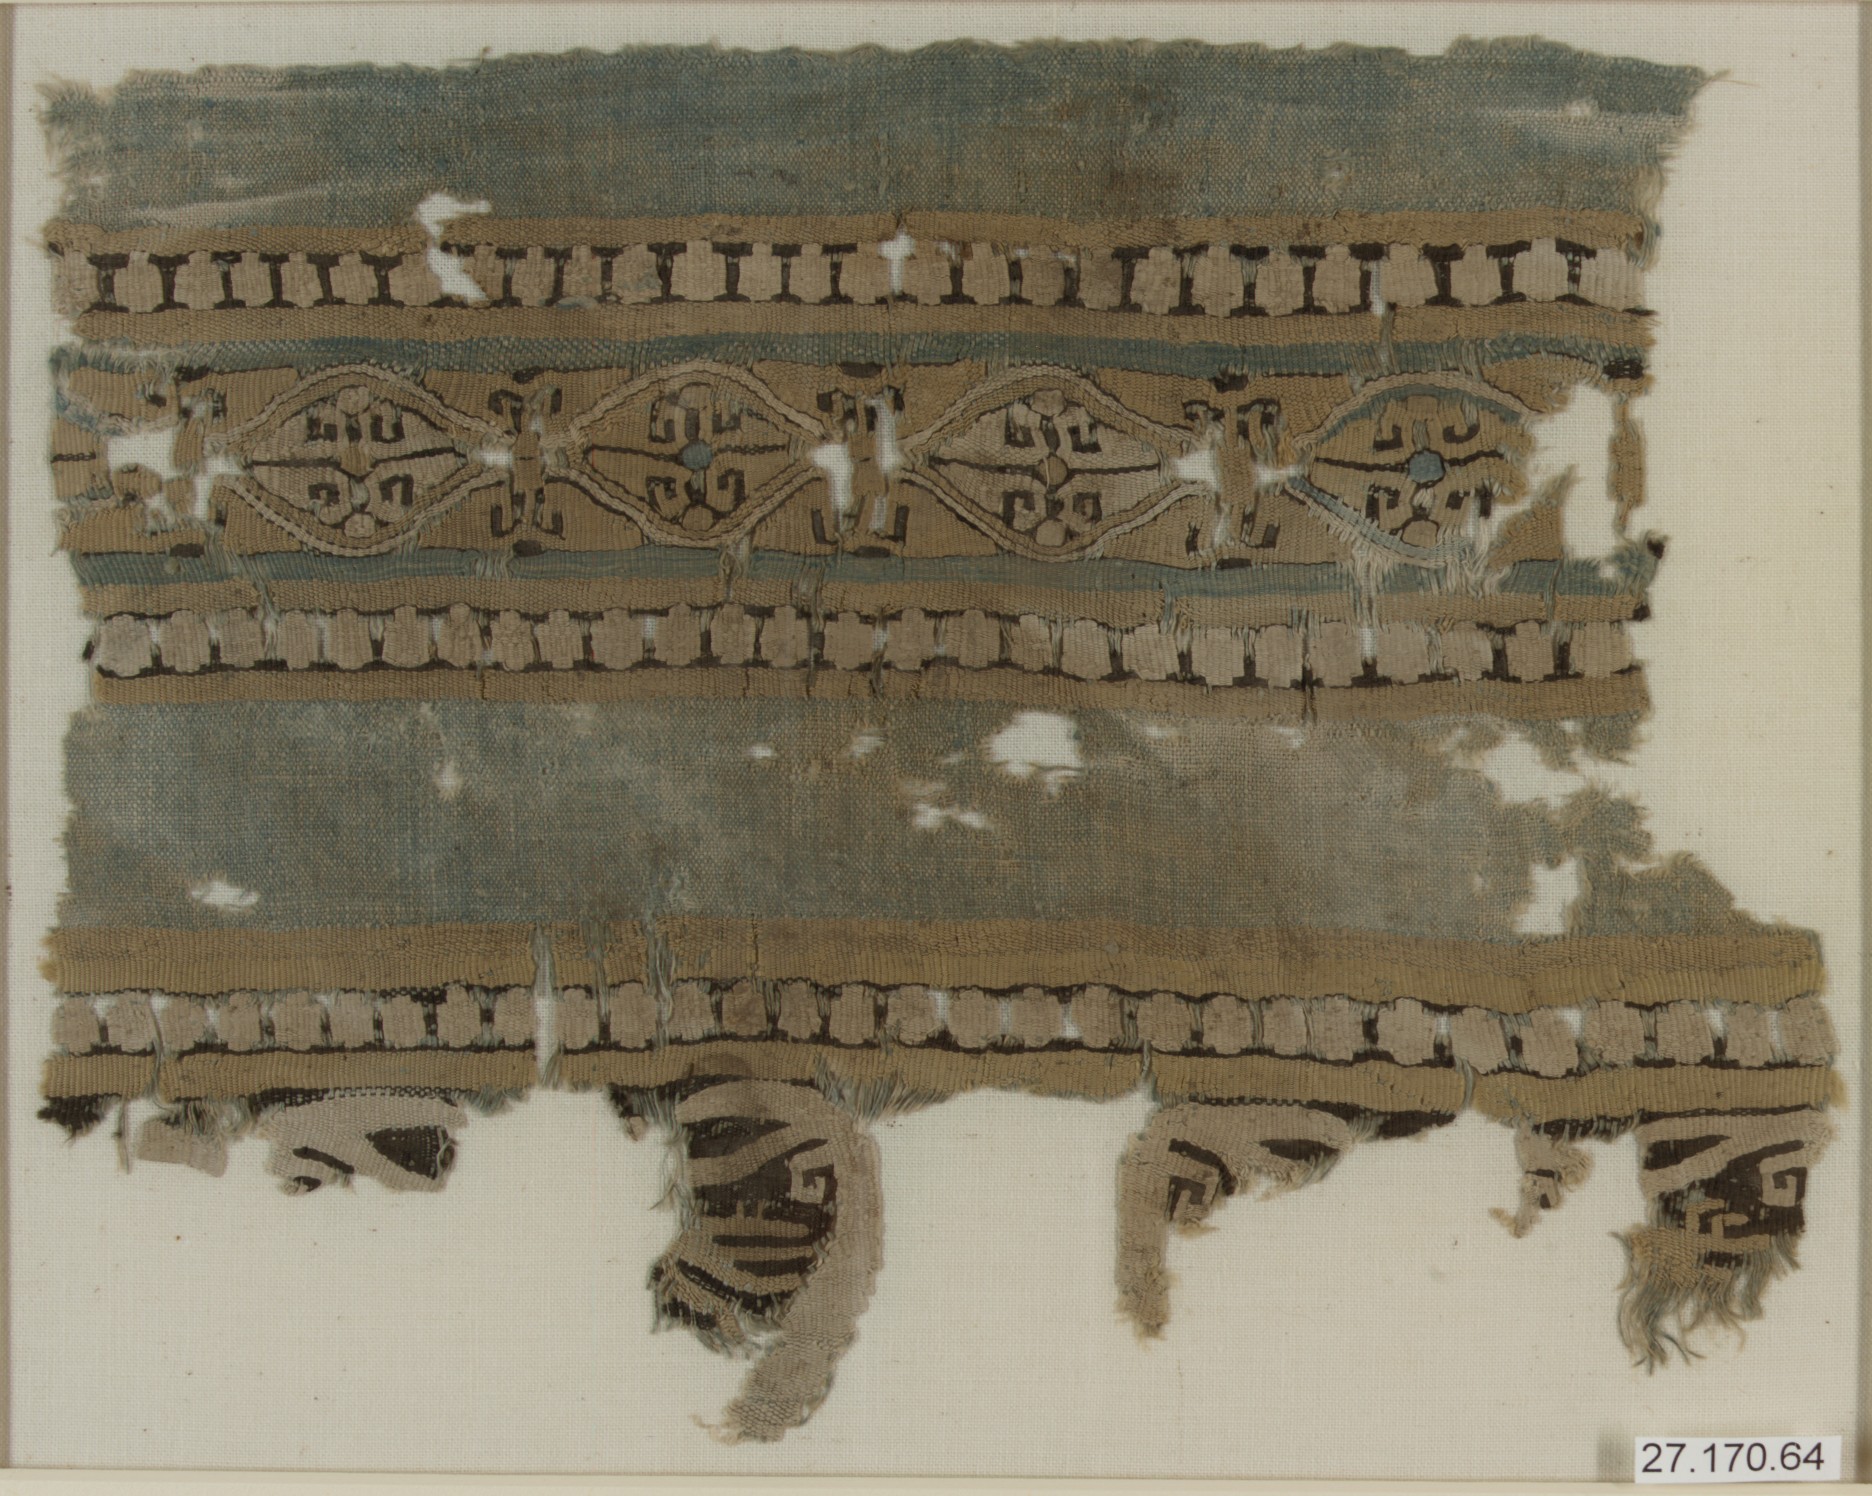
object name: textile fragment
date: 1101-1200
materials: linen, silk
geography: egypt